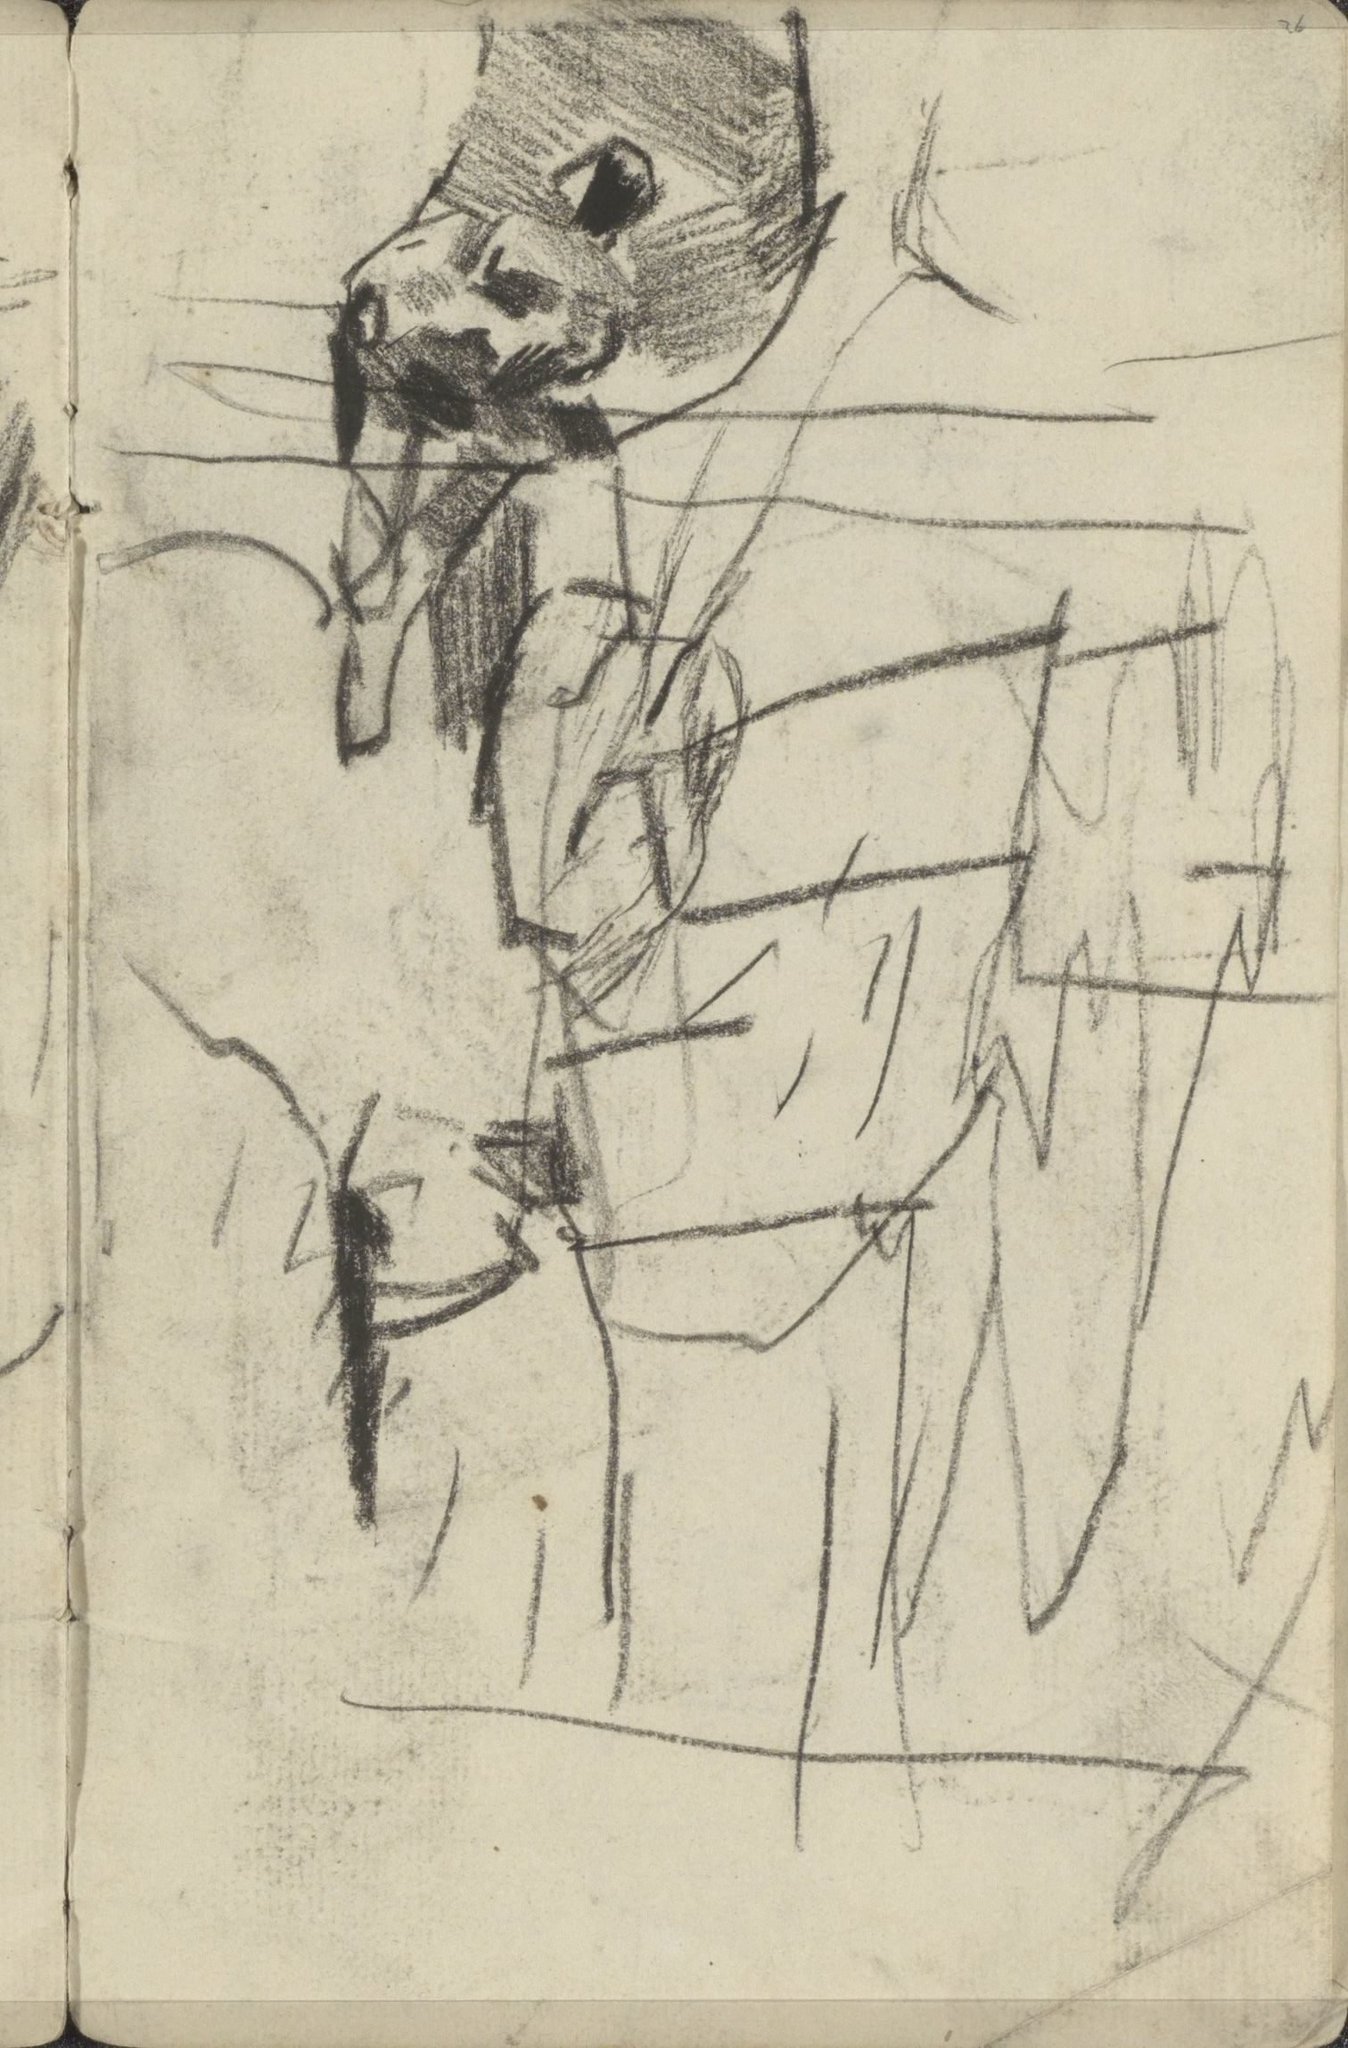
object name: sketchbook leaf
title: Liggende hond, mogelijk in een landschap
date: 1883-1885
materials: chalk, paper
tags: landscapes, dog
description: Pagina 26 uit een schetsboek met 16 bladen.